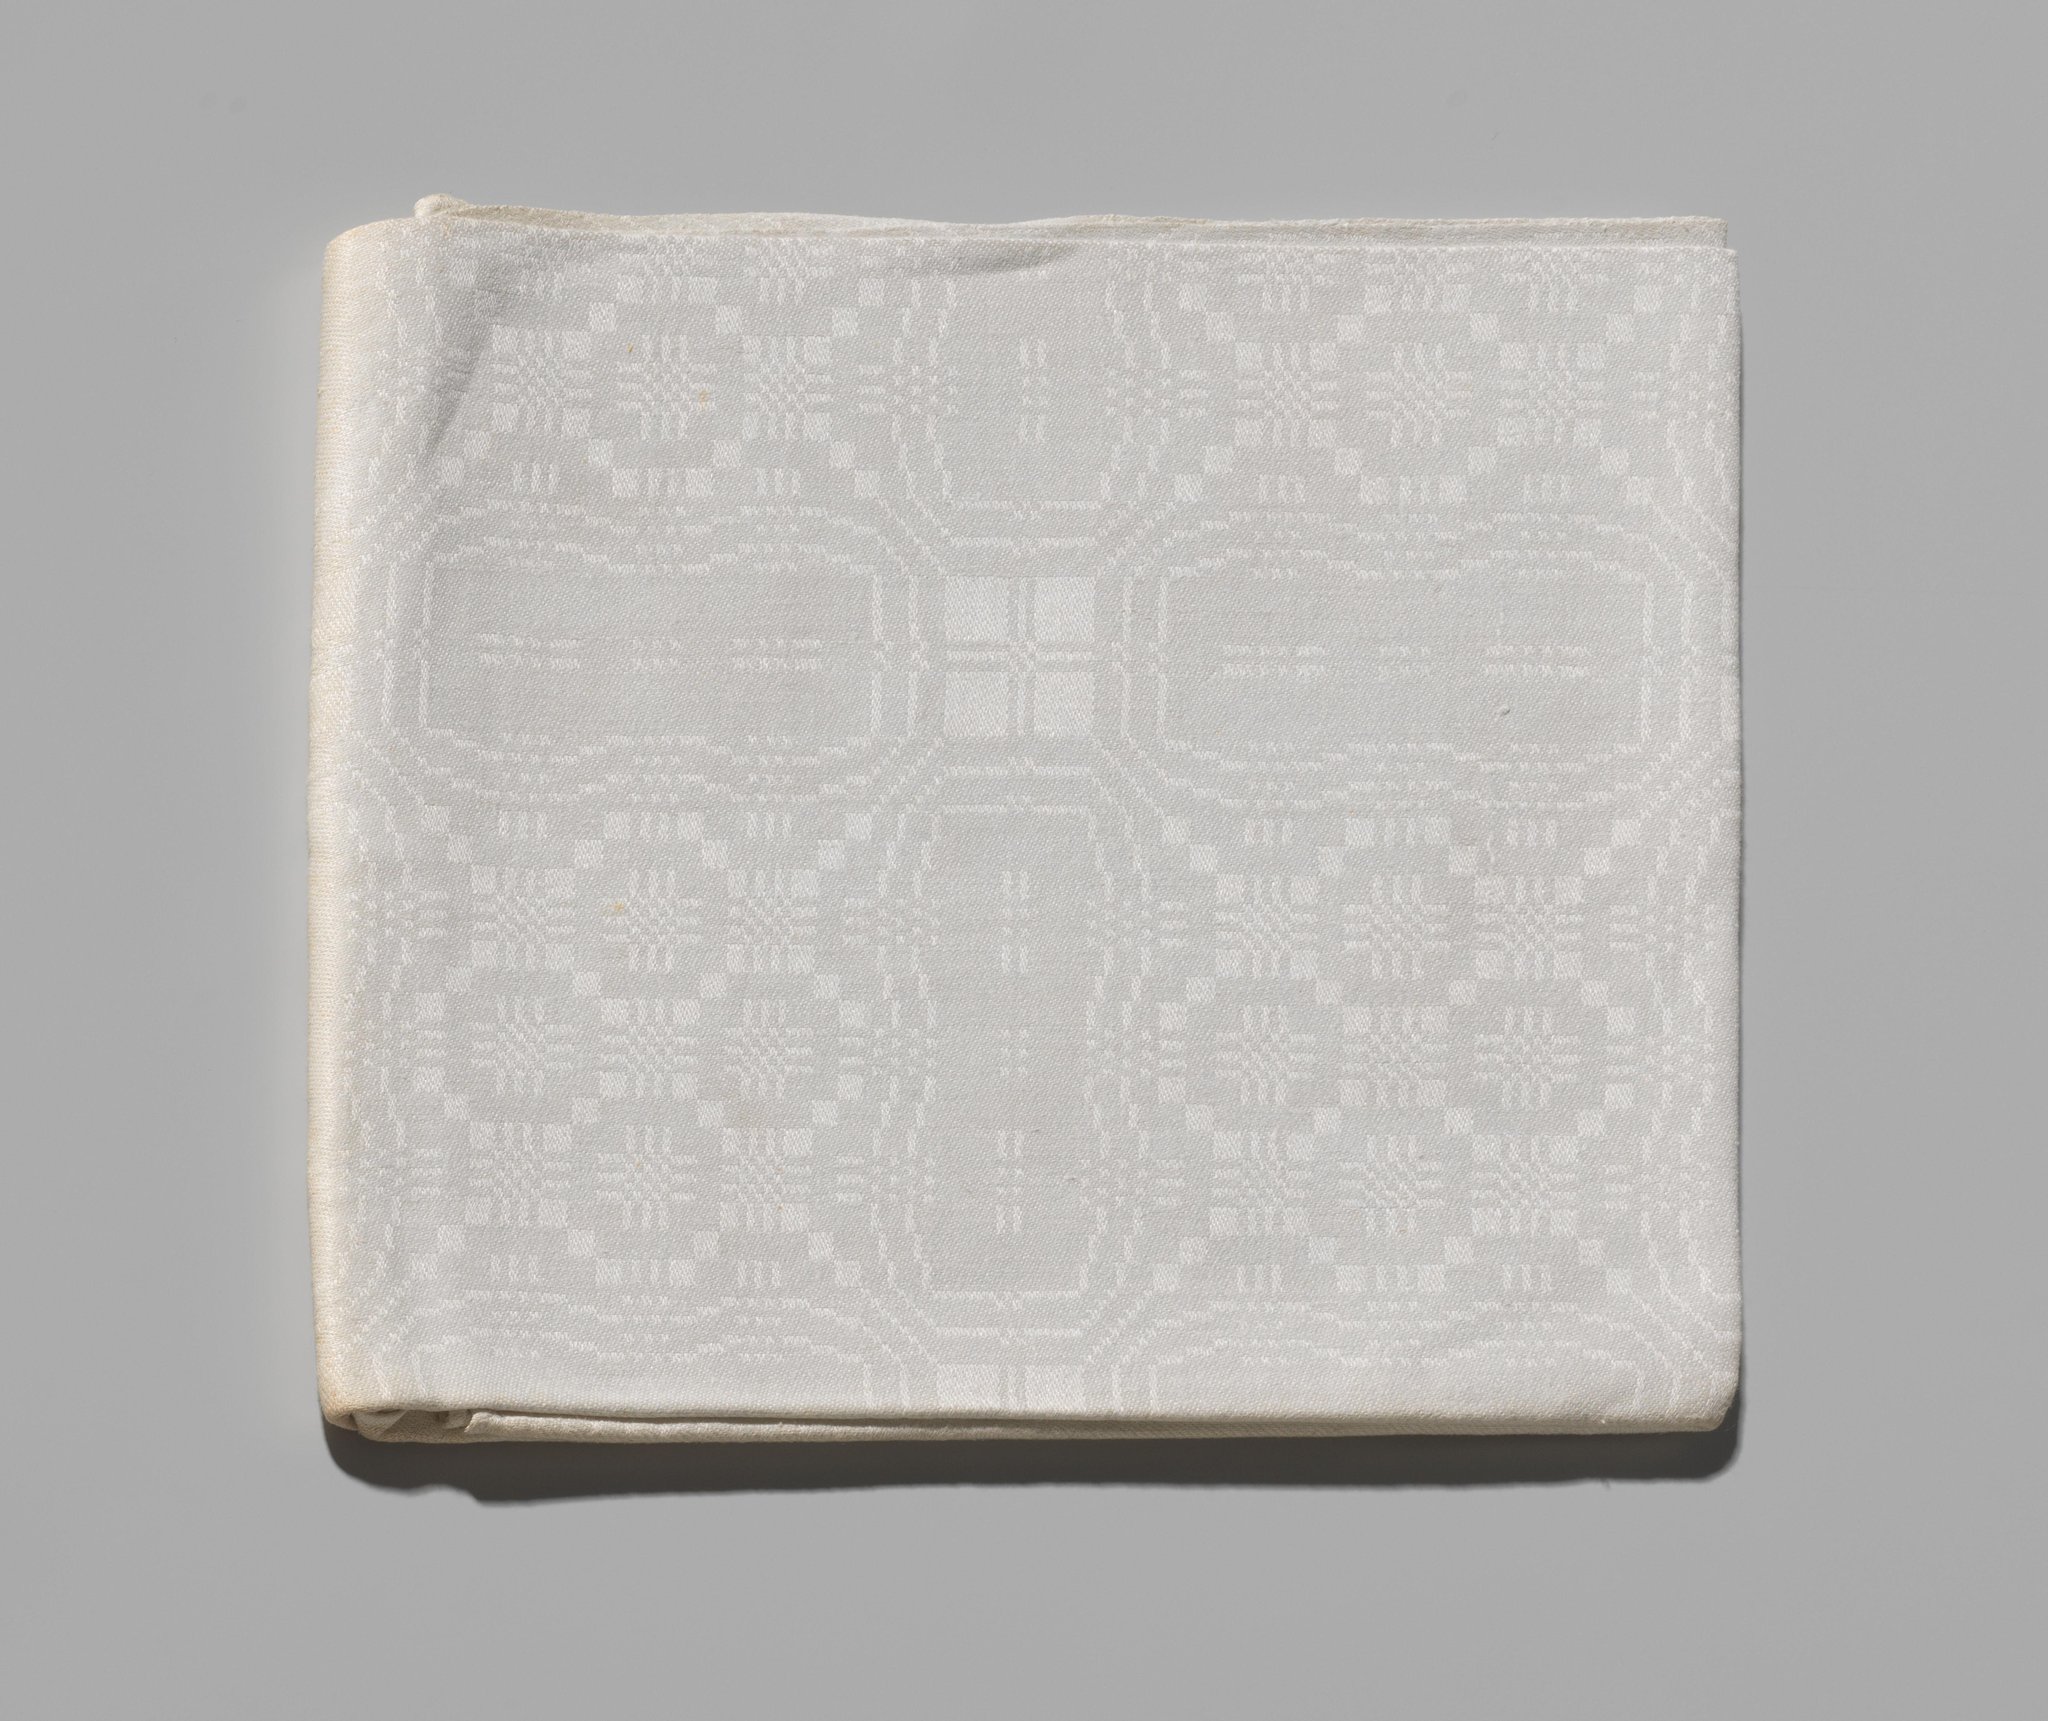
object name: napkin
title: Pellen. Merk geborduurd in de hoek: PP 12.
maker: Anonymous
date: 1800-1900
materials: linen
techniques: weave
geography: netherlands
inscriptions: monogram: ‘PP 12’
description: Servet van linnen pellendamast met randen rondom en in een hoek de geborduurde letters PP 12. Het servet hoort bij vijf servetten (BK-1980-161-A t/m BK-1980-161-F) en een tafellaken (BK-1980-160).